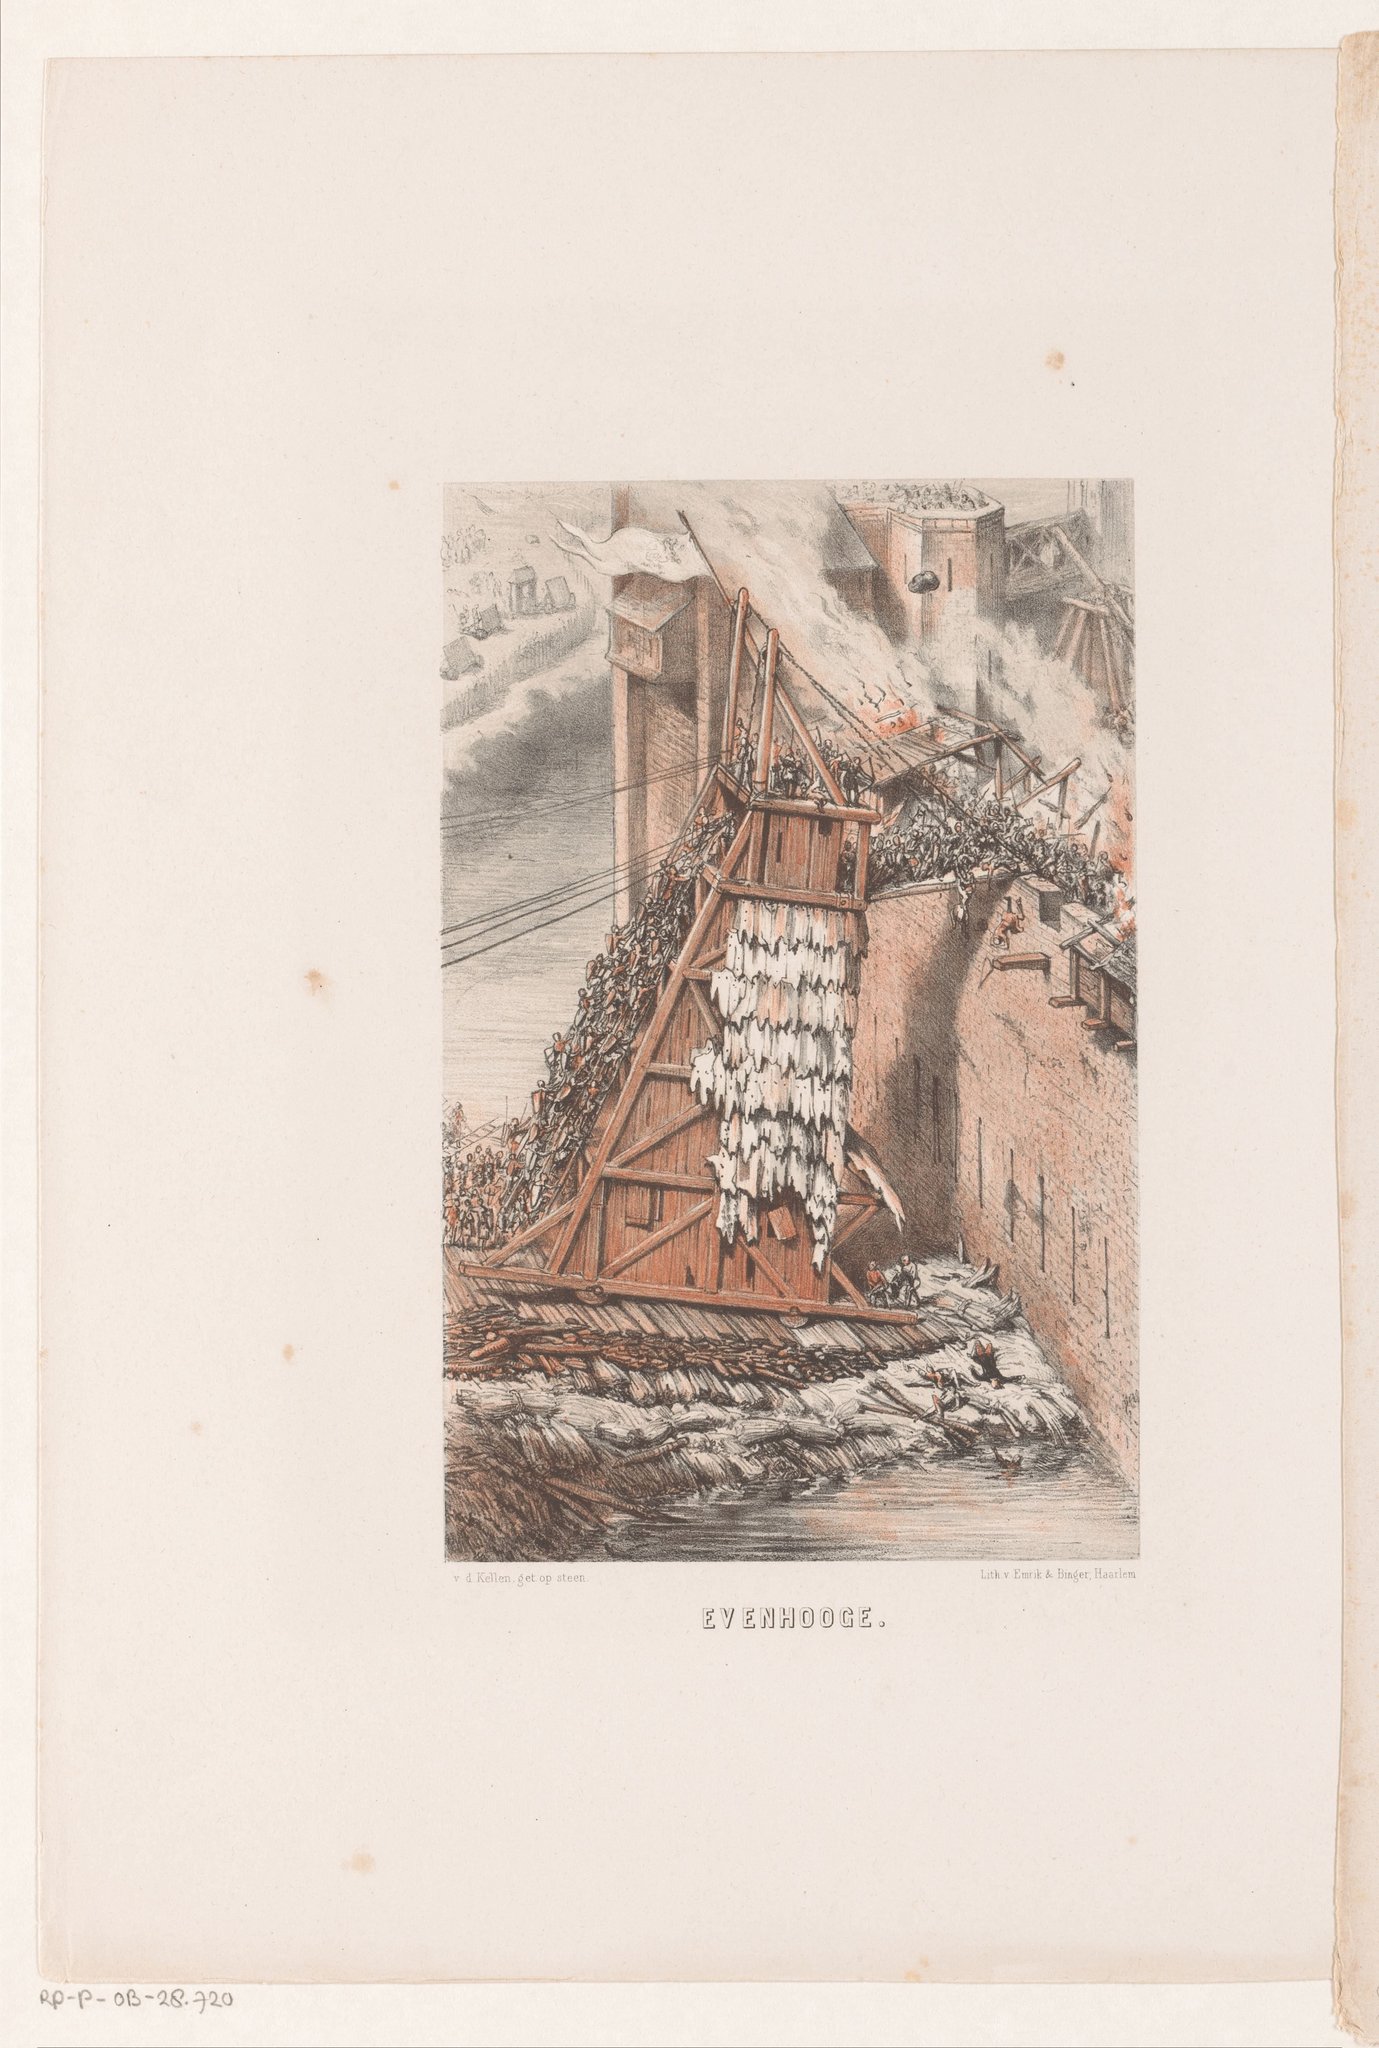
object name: historical object representation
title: Evenhooge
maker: david van der kellen (1827-1895)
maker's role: draughtsman, print maker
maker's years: 1827-1895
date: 1857-1864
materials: paper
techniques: tone lithography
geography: haarlem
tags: siege arms, e.g.: battering ram, siege, netherlands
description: Illustratie voor: W.J. Hofdijk, Ons voorgeslacht in zijn dagelyksch leven geschilderd, Kruseman, Haarlem 1859-1864.